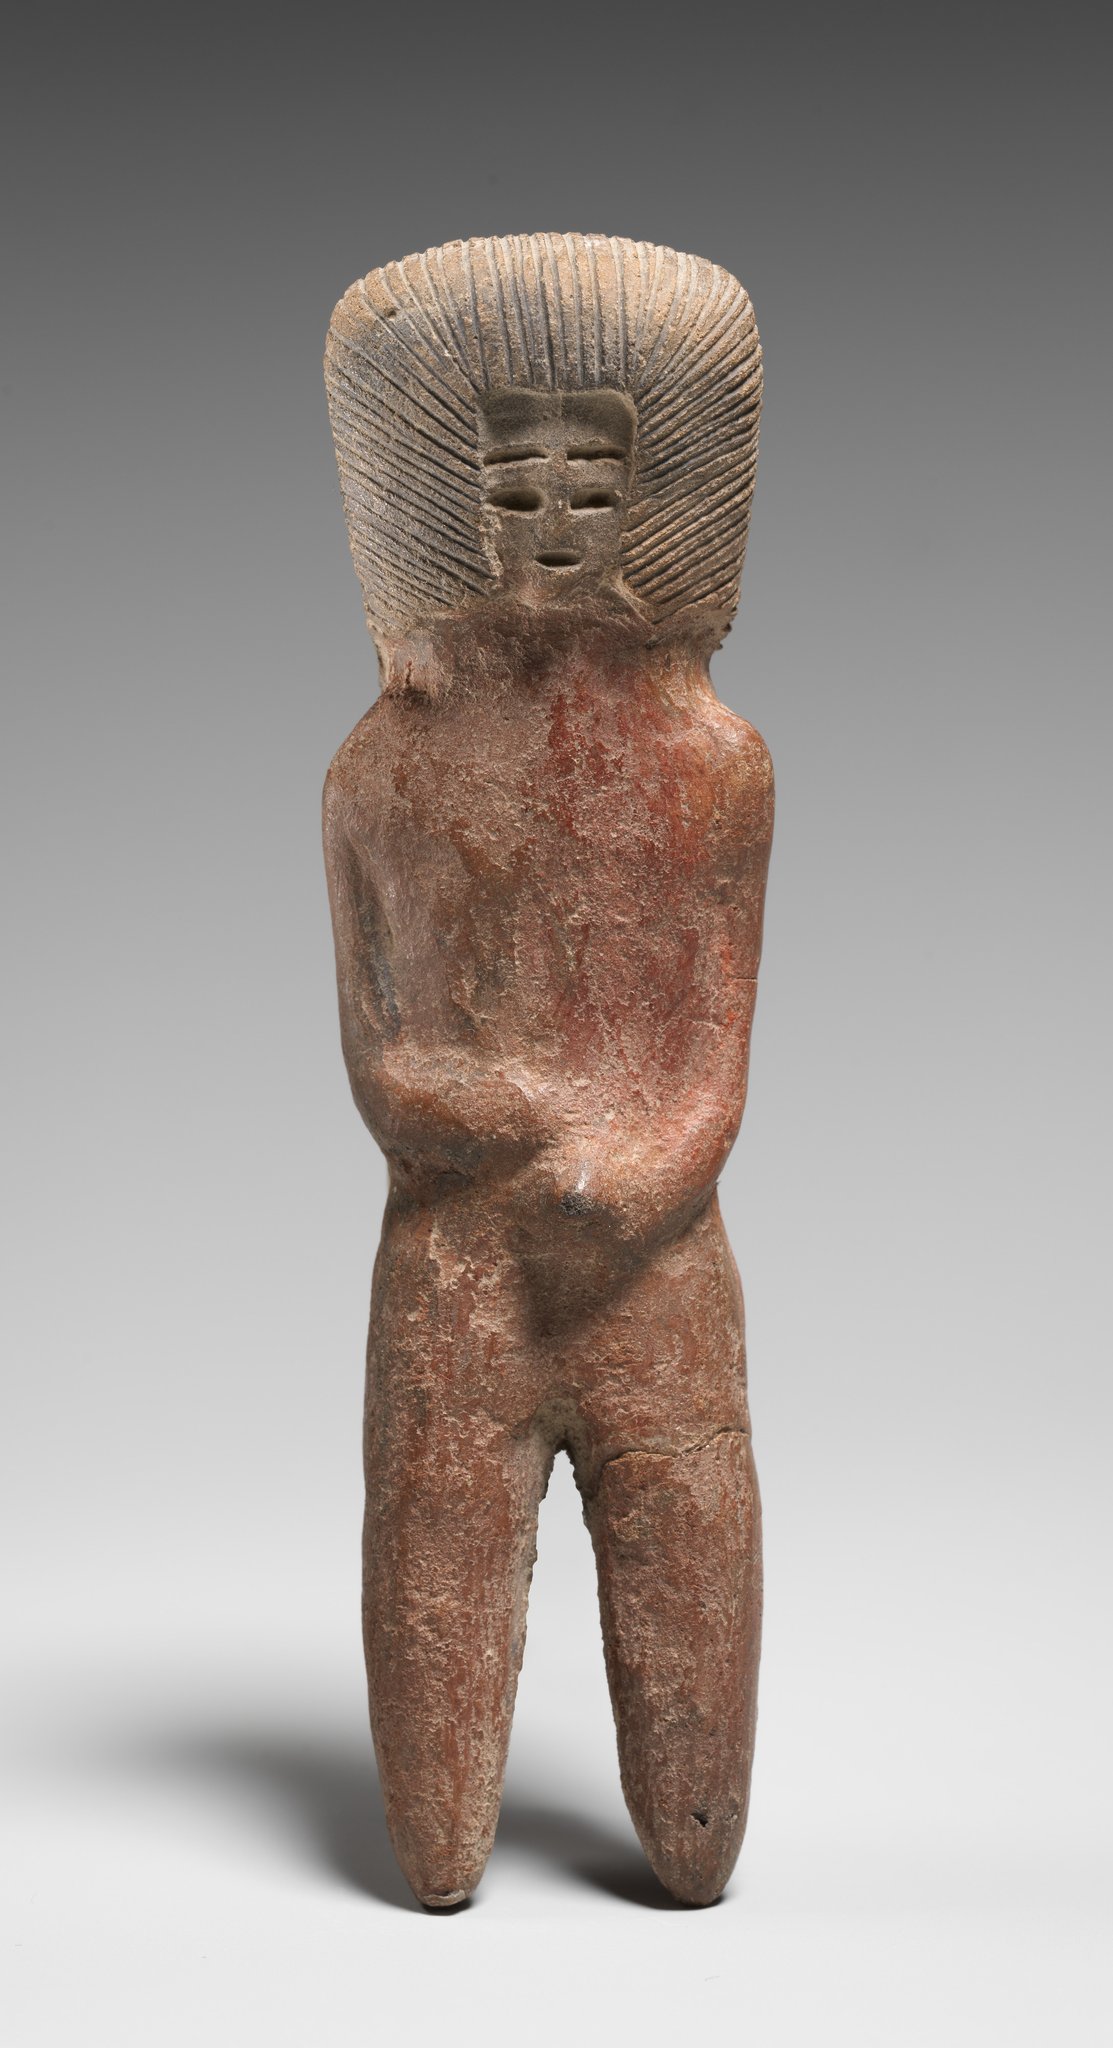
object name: male figure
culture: valdivia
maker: valdivia artist(s)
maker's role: artist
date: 3000 BCE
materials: ceramic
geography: ecuador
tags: men